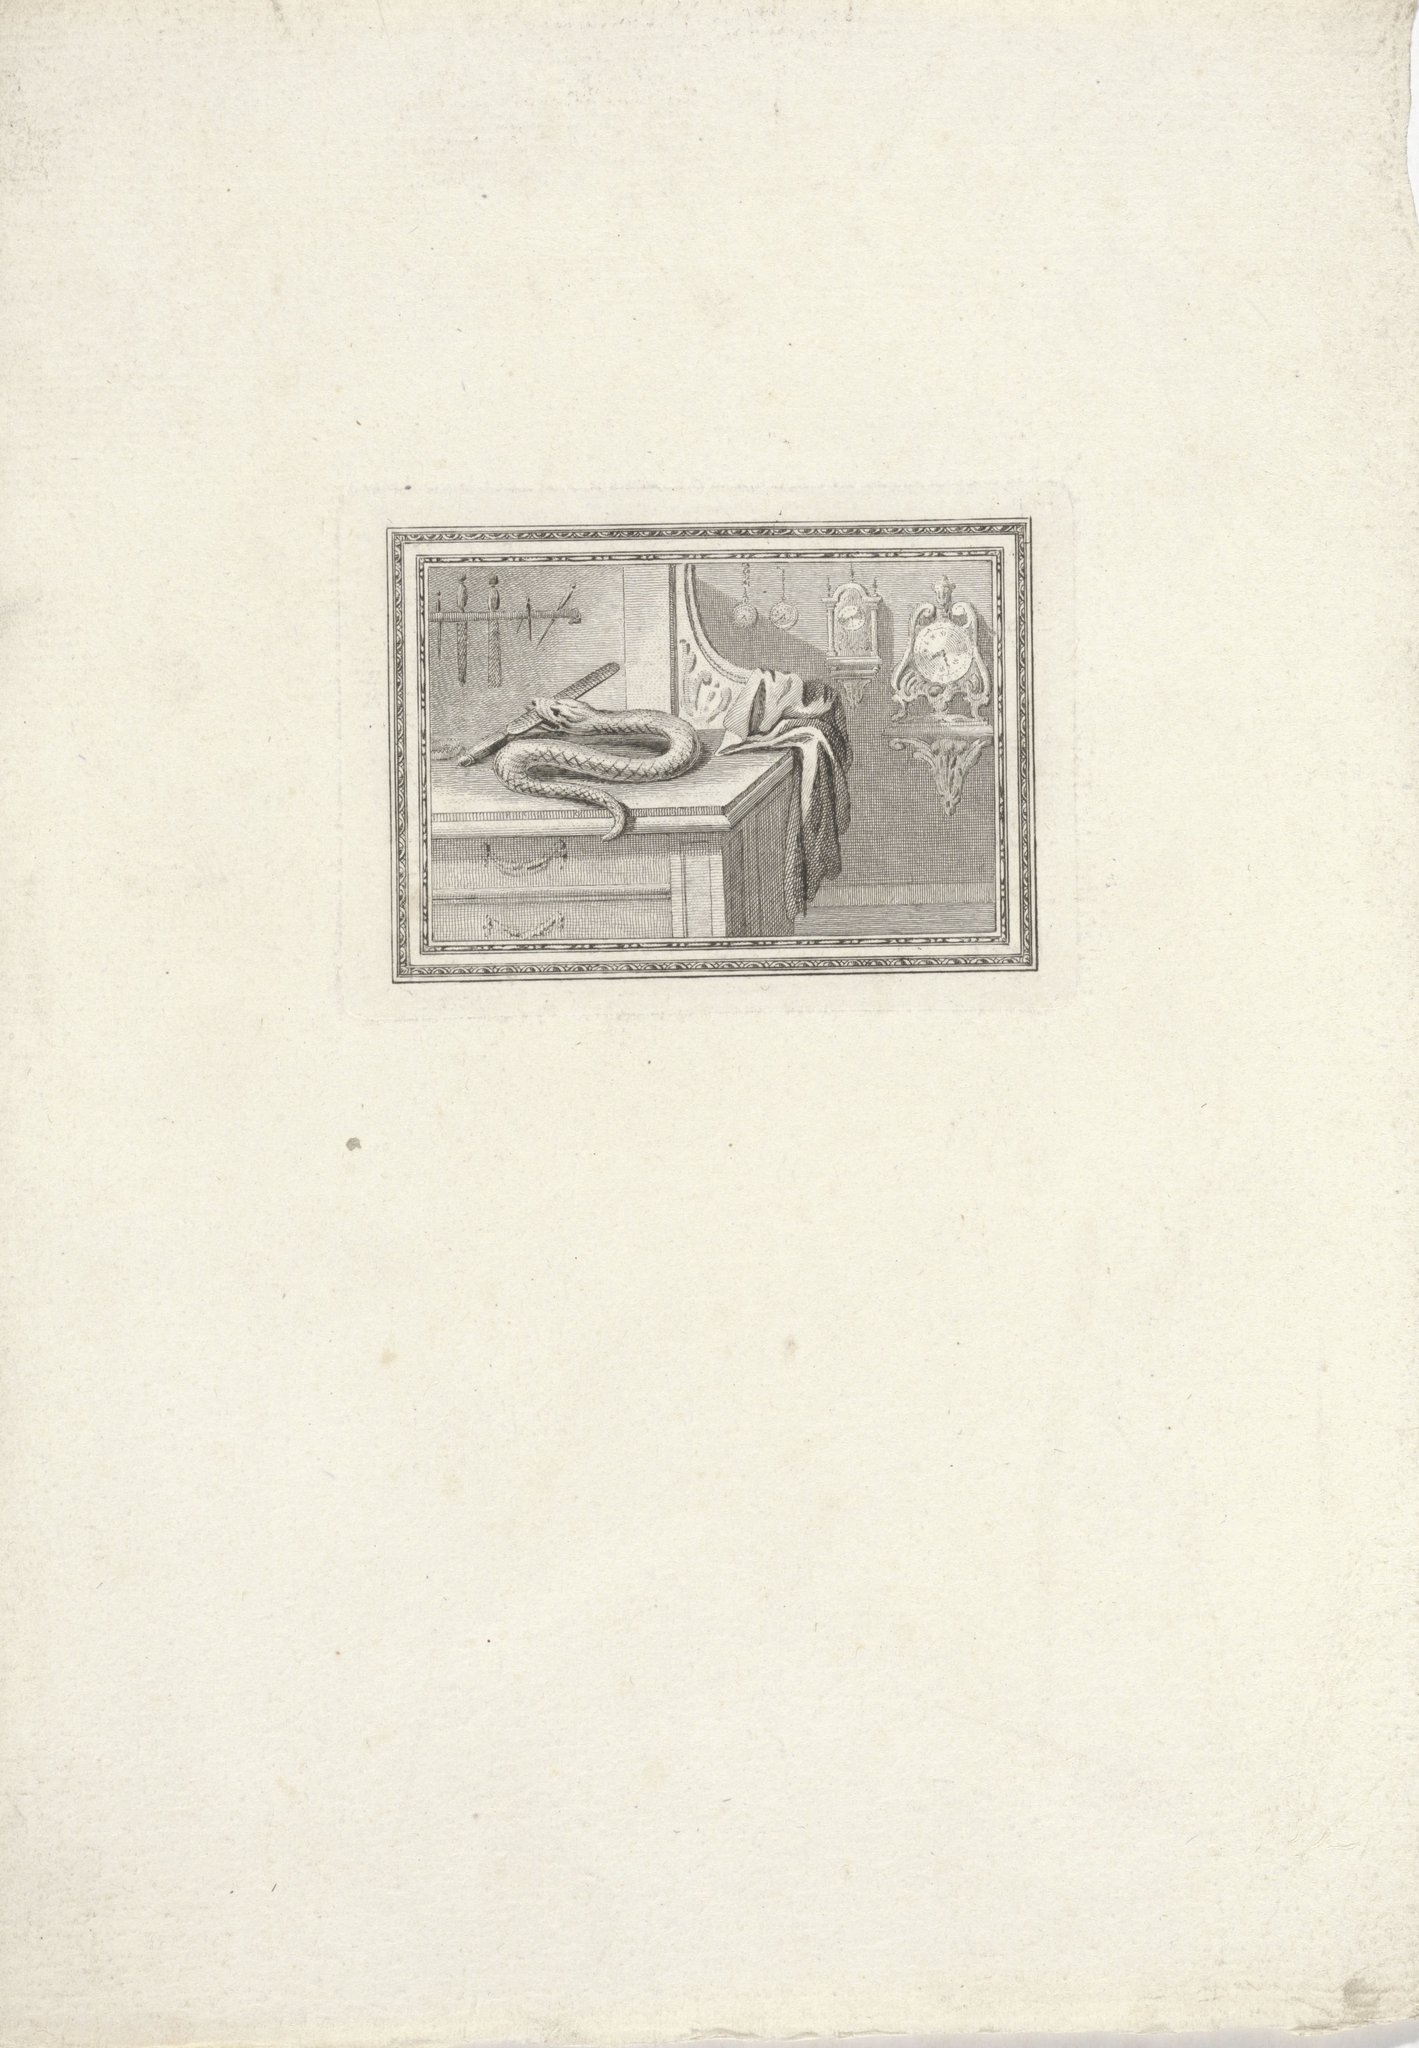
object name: print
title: Slang met een vijl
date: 1792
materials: paper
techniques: etching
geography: amsterdam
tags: snakes, tools, aids, implements ~ crafts and industries: file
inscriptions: collector's mark: Lugt 2228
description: Een slang probeert zonder succes een vijl op te eten. Illustratie bij het verhaal 'De slang en de veil' uit 'Fabelen voor de Nederlandsche jeugd'.